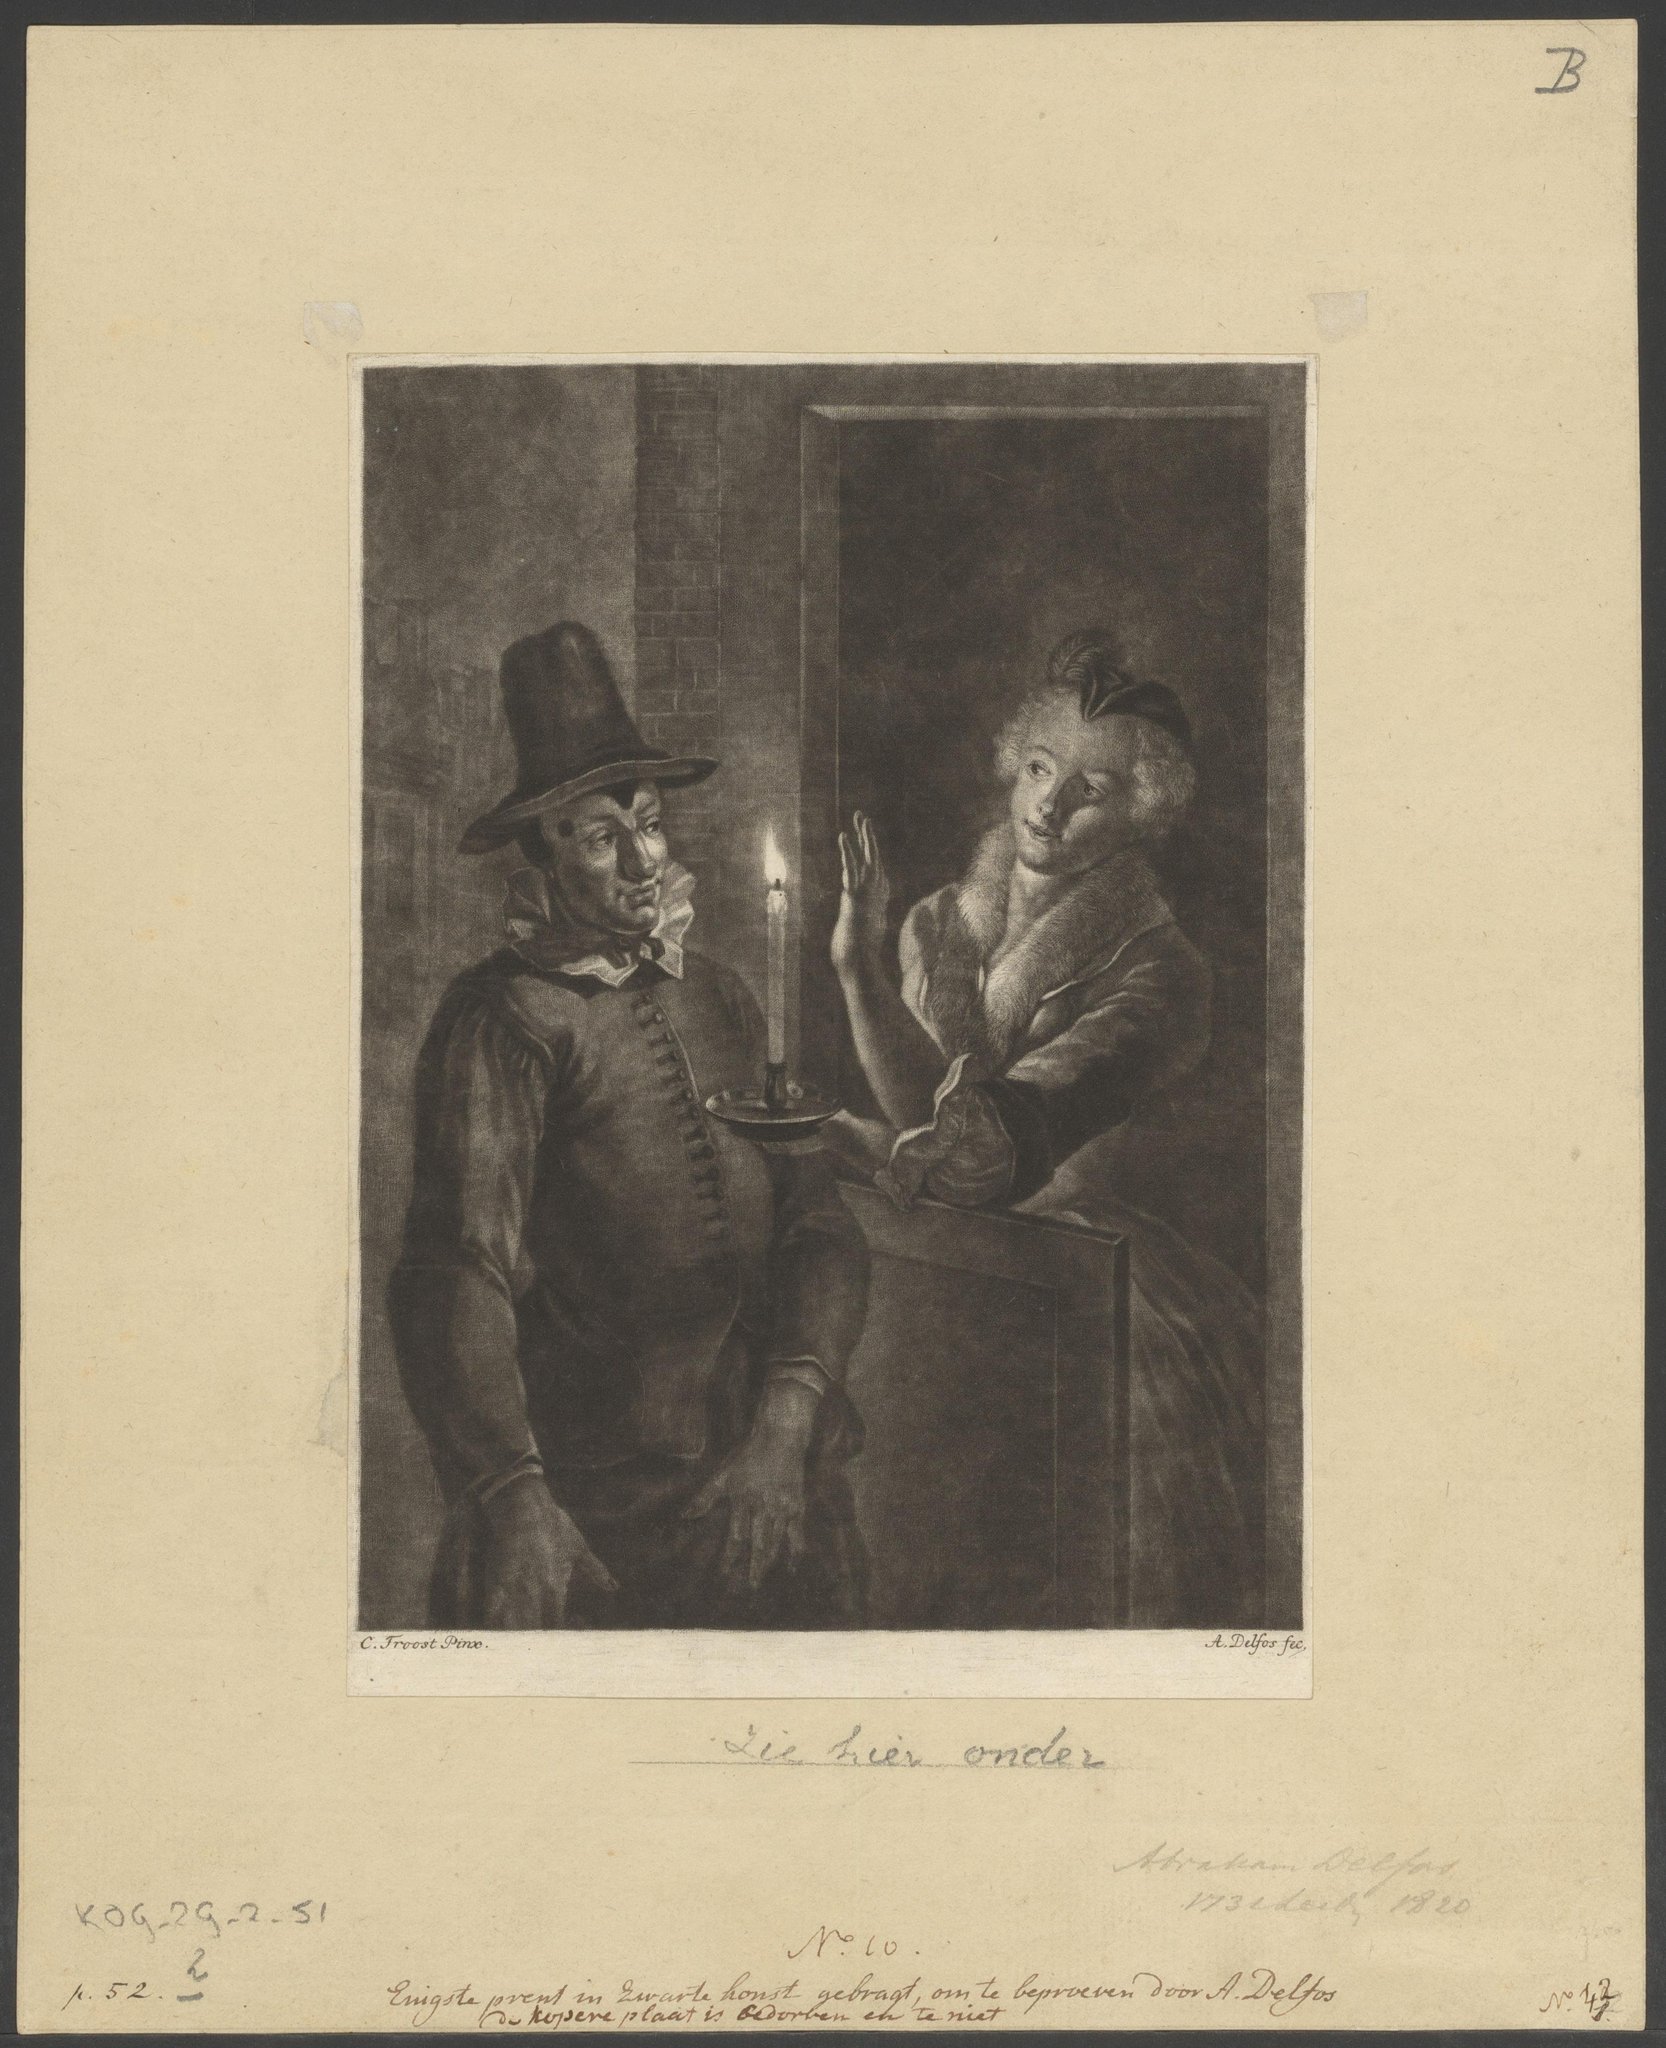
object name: print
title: Jan Claasz of de gewaande dienstmaagd: de liefdesverklaring van Reinier Adriaansz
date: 1741-1820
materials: paper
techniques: mezzotint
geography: haarlem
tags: candle, proposal, declaration of love, comedy, night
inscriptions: collector's mark: Lugt 2488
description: Nachtgezicht. Reinier Adriaansz verklaart Saartje Jansz de liefde. Zij staat met een kaars in de deuropening. De prent verbeeldt een scène uit de komedie 'Jan Claasz of de gewaande dienstmaagd' van Thomas Asselijn.